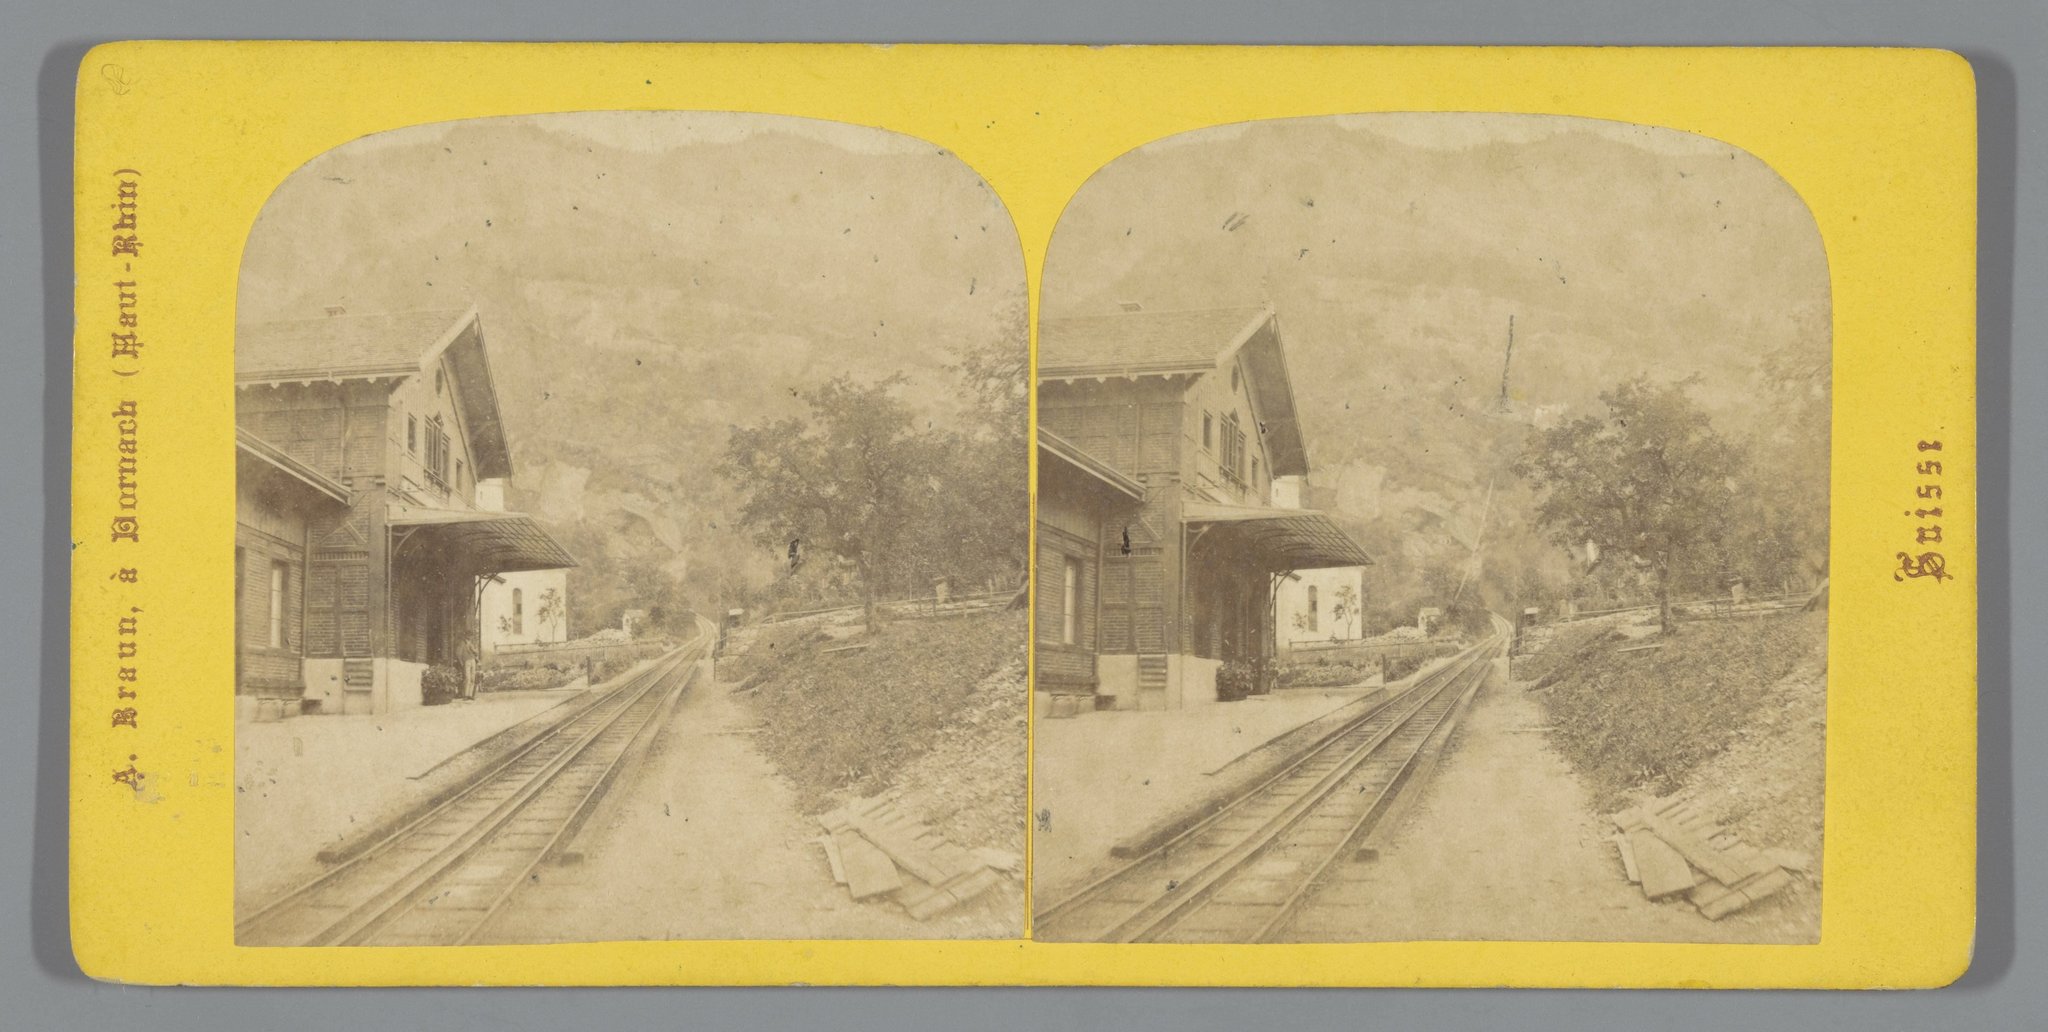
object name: stereograph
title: Station langs de spoorlijn van Vitznau naar de Rigi, Zwitserland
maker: Anonymous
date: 1879-1889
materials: cardboard, paper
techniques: albumen print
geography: dornach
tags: railway, train, mountains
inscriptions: number: ‘42.’, number: ‘6207’, inscription: ‘Vitznau / Zwitserland /’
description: Het traject van de Vitznau-Rigi-Bahn werd op 21 mei 1871 geopend en loopt van Vitznau gelegen in Luzern naar Rigi Staffelhöhe gelegen in Schwyz. Het traject van Rigi Staffelhöhe naar Rigi Kulm werd op 23 juni 1873 geopend.